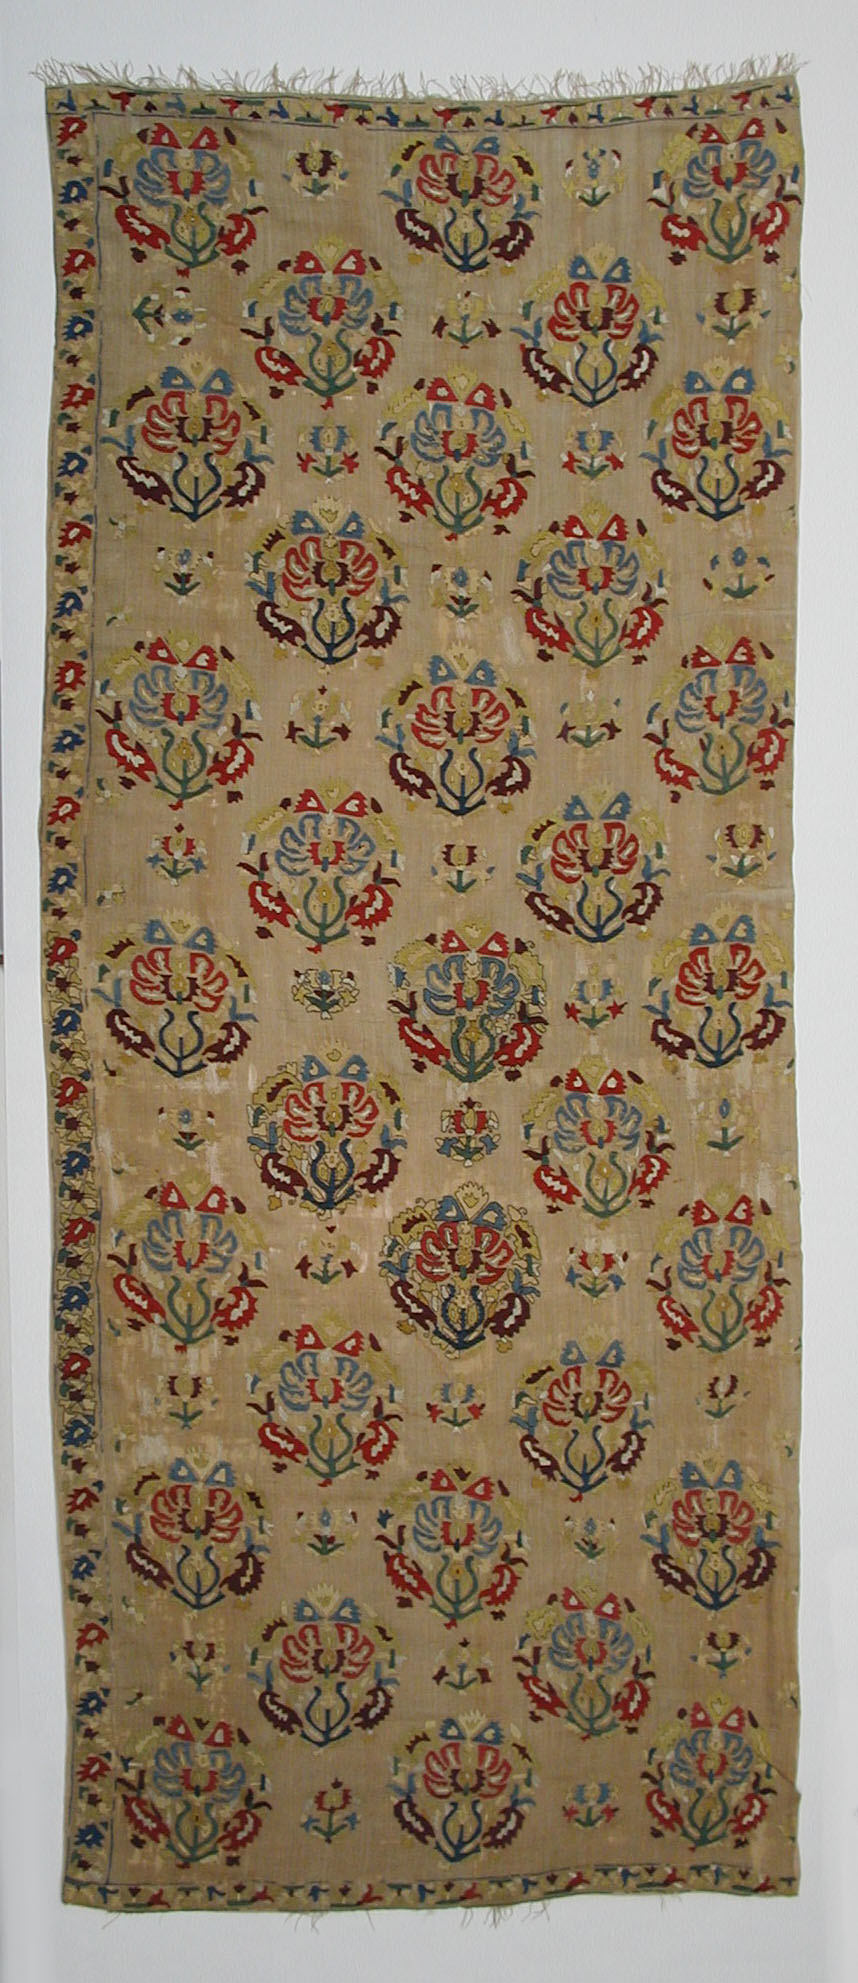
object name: textile fragment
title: Fragment of a Cover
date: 1701-1800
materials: linen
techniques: embroidery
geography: turkey